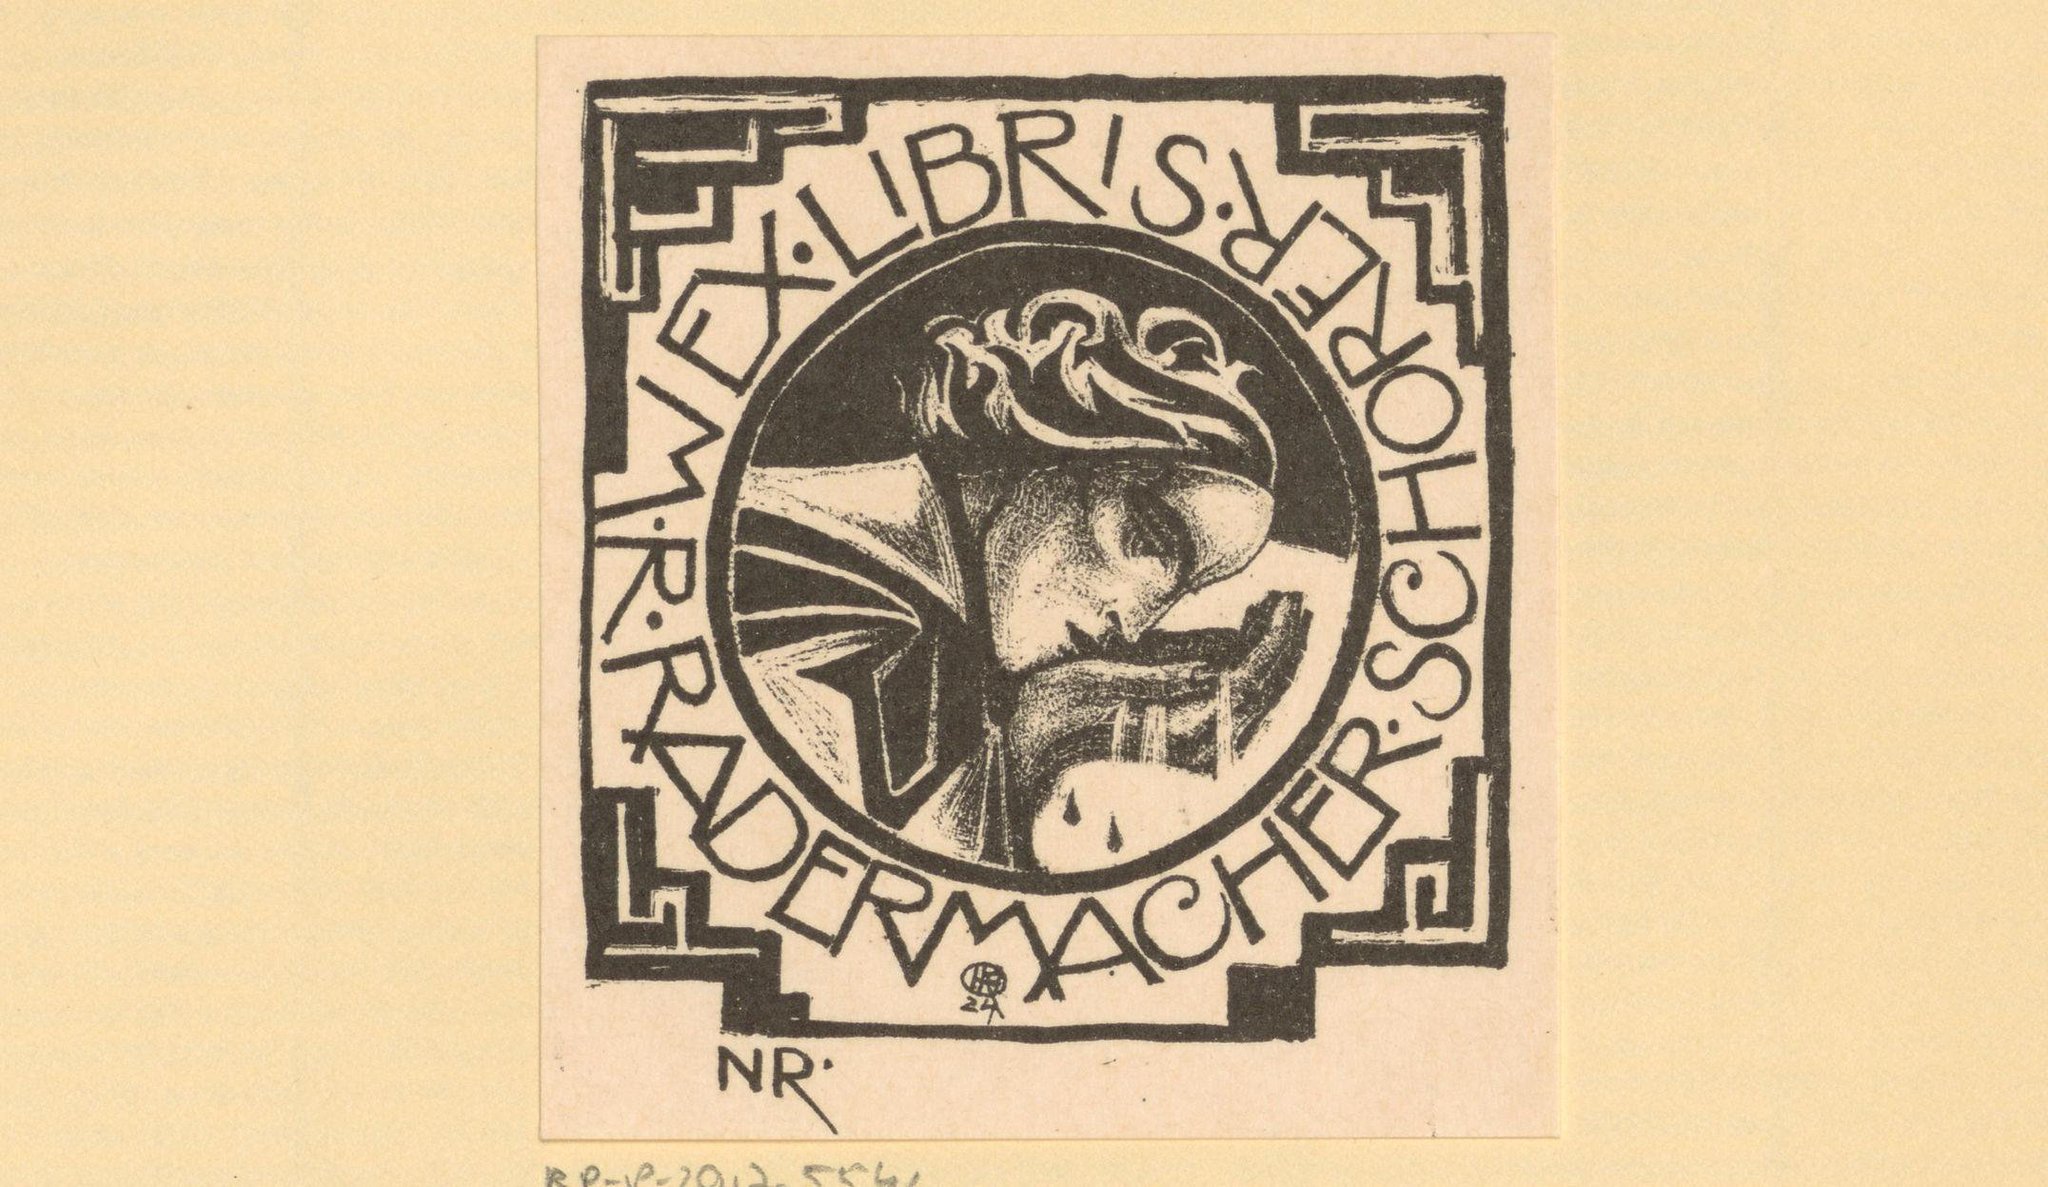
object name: bookplate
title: Ex libris van M.R. Radermacher Schorer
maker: richard nicolaüs roland holst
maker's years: 1868-1938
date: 1924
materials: paper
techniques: lithograph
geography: netherlands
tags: utrecht, head (human), drinking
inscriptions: date